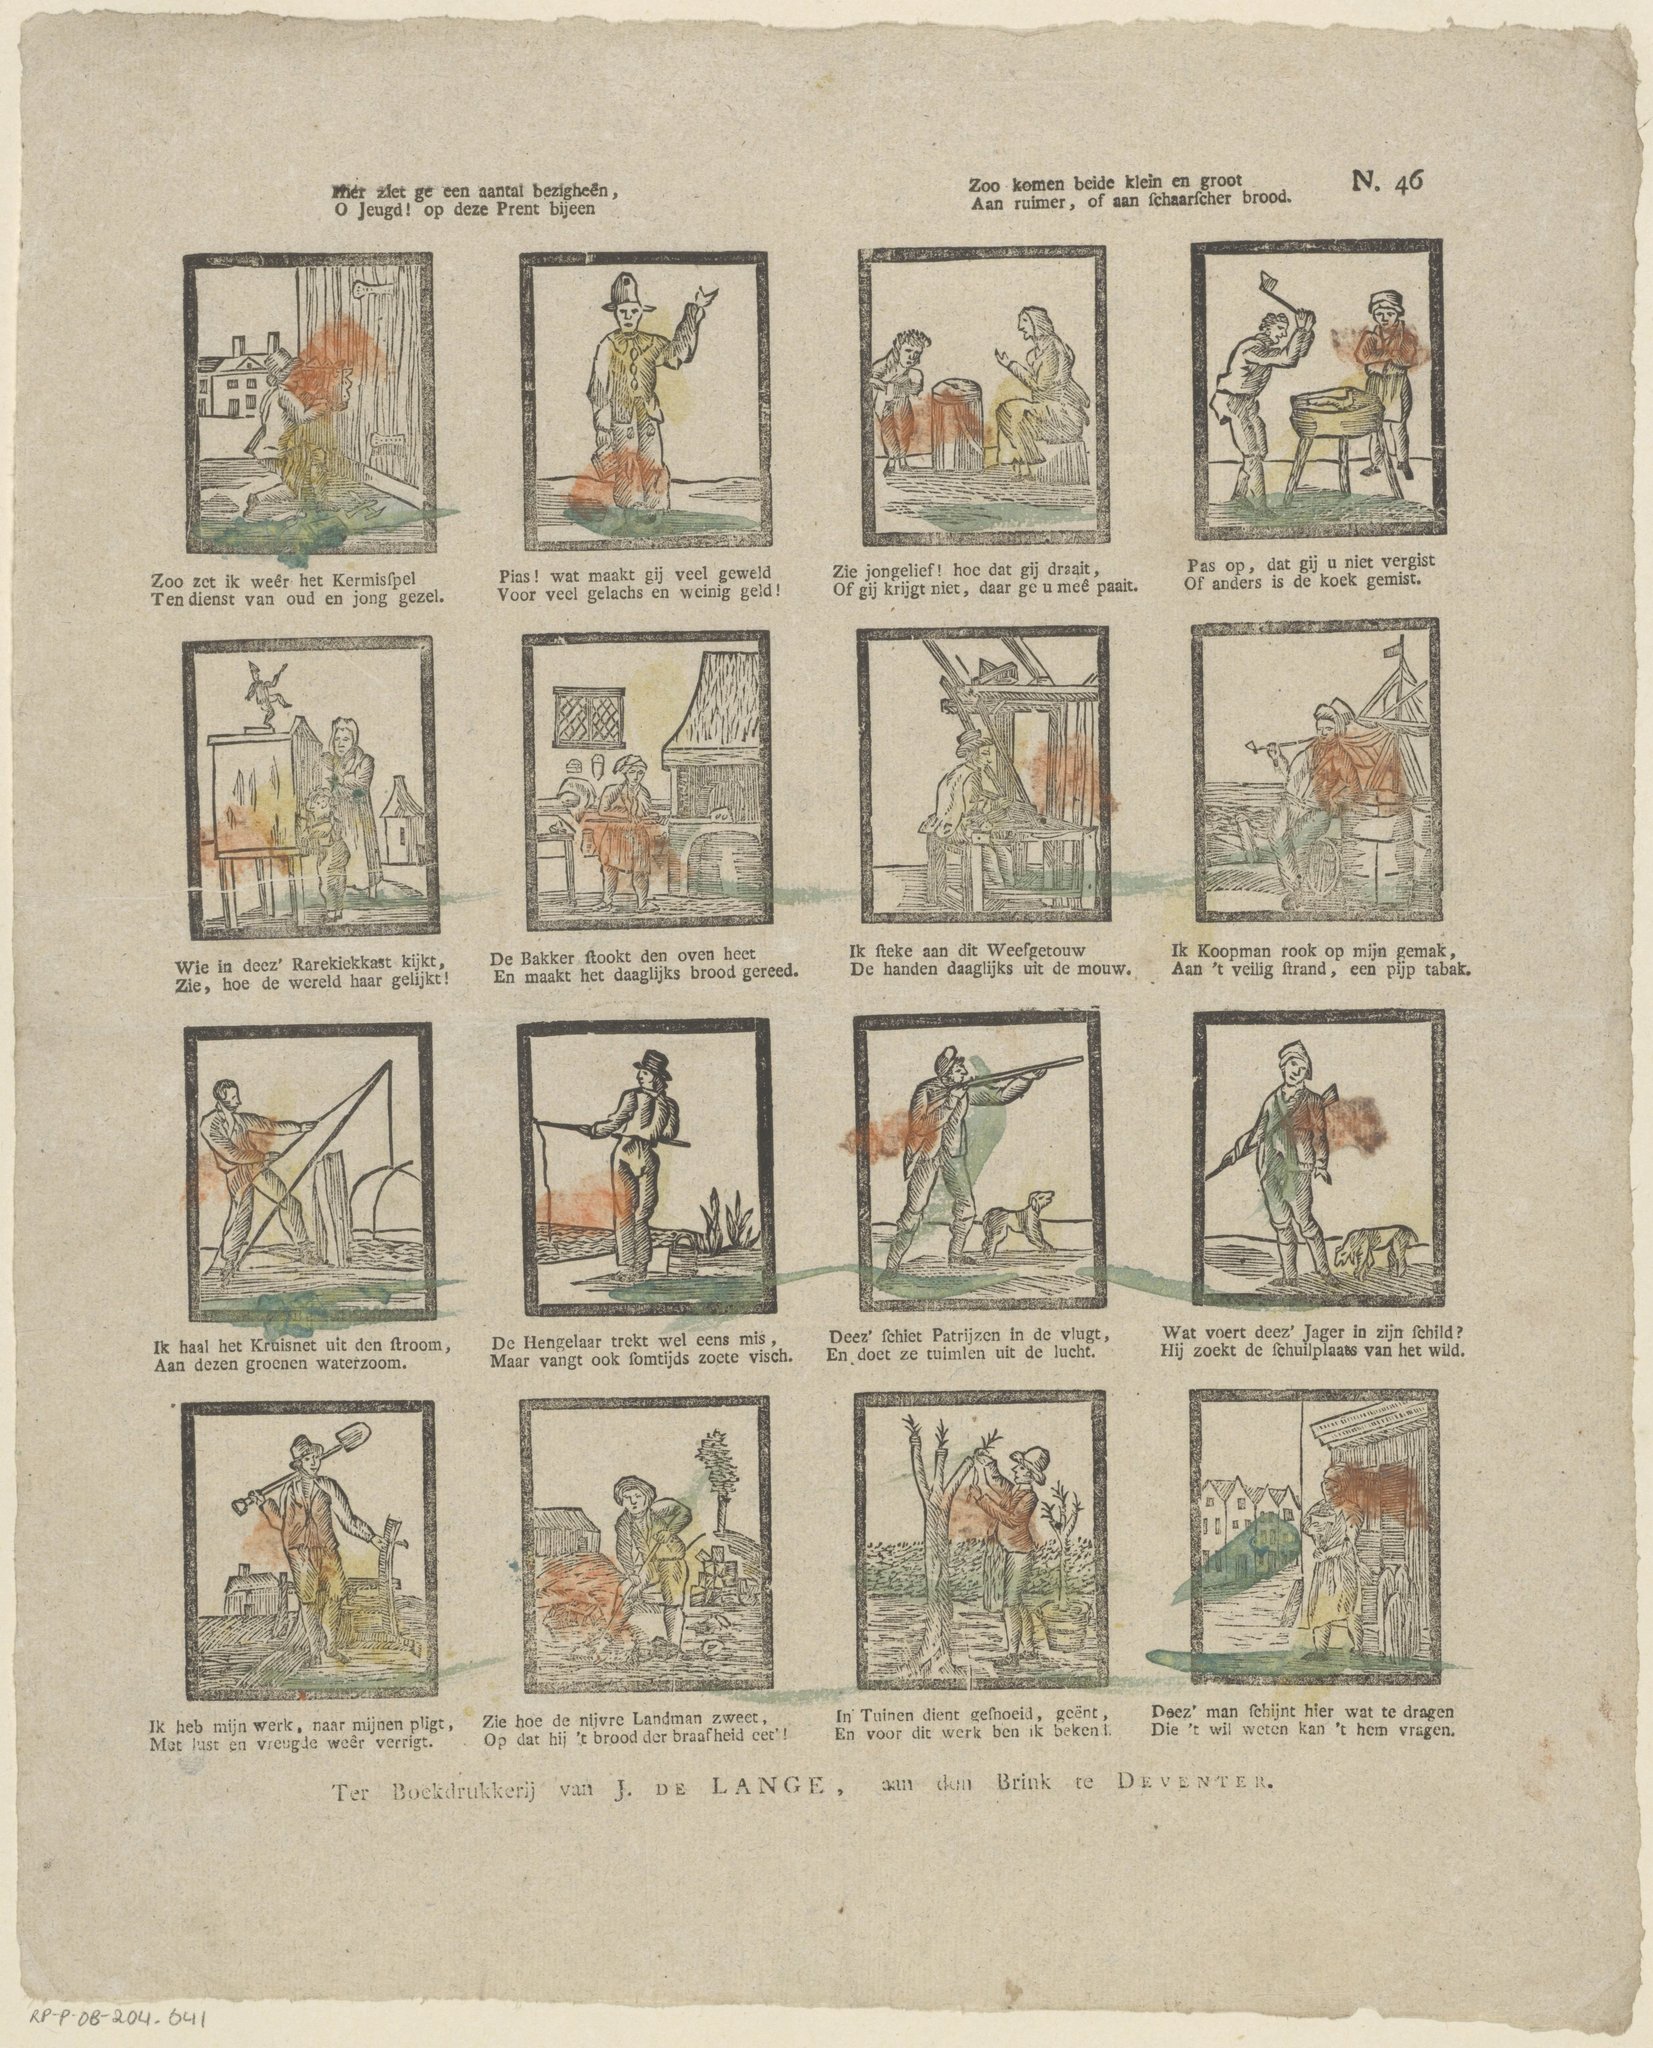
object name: popular print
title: Hier ziet ge een aantal bezigheên, / O jeugd! op deze prent bijeen / Zoo komen beide klein en groot / Aan ruimer, of aan schaarscher brood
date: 1822-1849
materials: paper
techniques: colour, letterpress printing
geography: netherlands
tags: craft-production, skilled handiwork, human types, hunter, working class, labourers, fishing (sports), crafts and industries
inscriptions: collector's mark: Lugt 2760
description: Blad met 16 voorstellingen van verschillende beroepen en bezigheden, zoals een bakker, een wever en een koopman. Onder elke afbeelding een tweeregelig vers. Genummerd rechtsboven: N. 46.